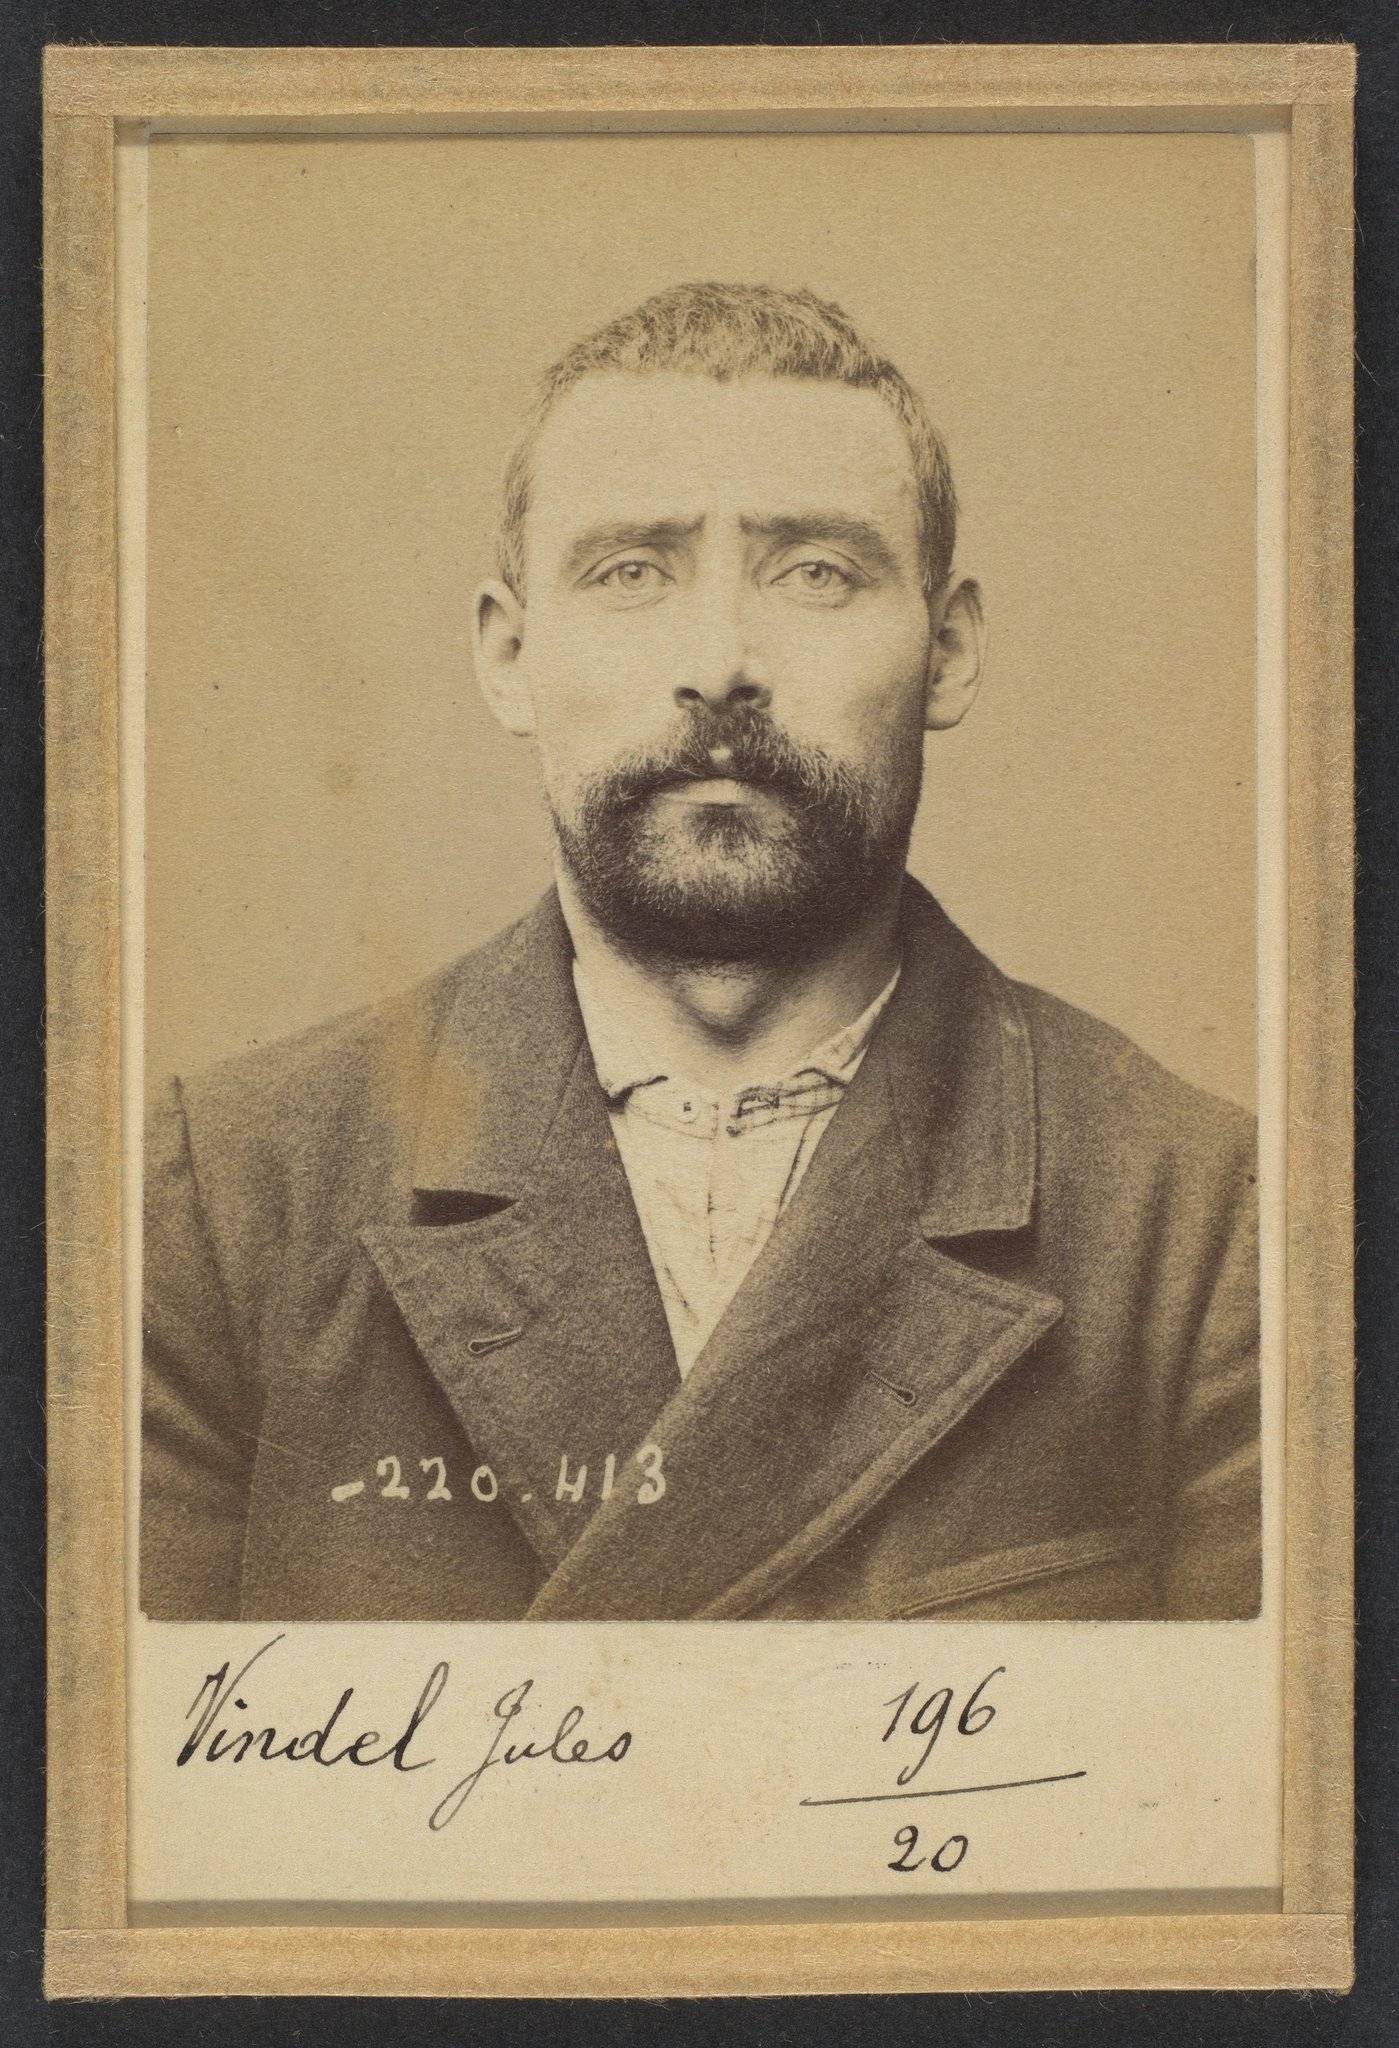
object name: mugshot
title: Vendel. Jules. 34 (ou 33) ans, né le 2/4/61 à Chevry (Ain). Garçon de cuisine. Anarchiste. 2/7/94.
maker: alphonse bertillon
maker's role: artist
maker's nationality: french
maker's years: 1853-1914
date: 1894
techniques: albumen silver print, glass negative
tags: men,portraits